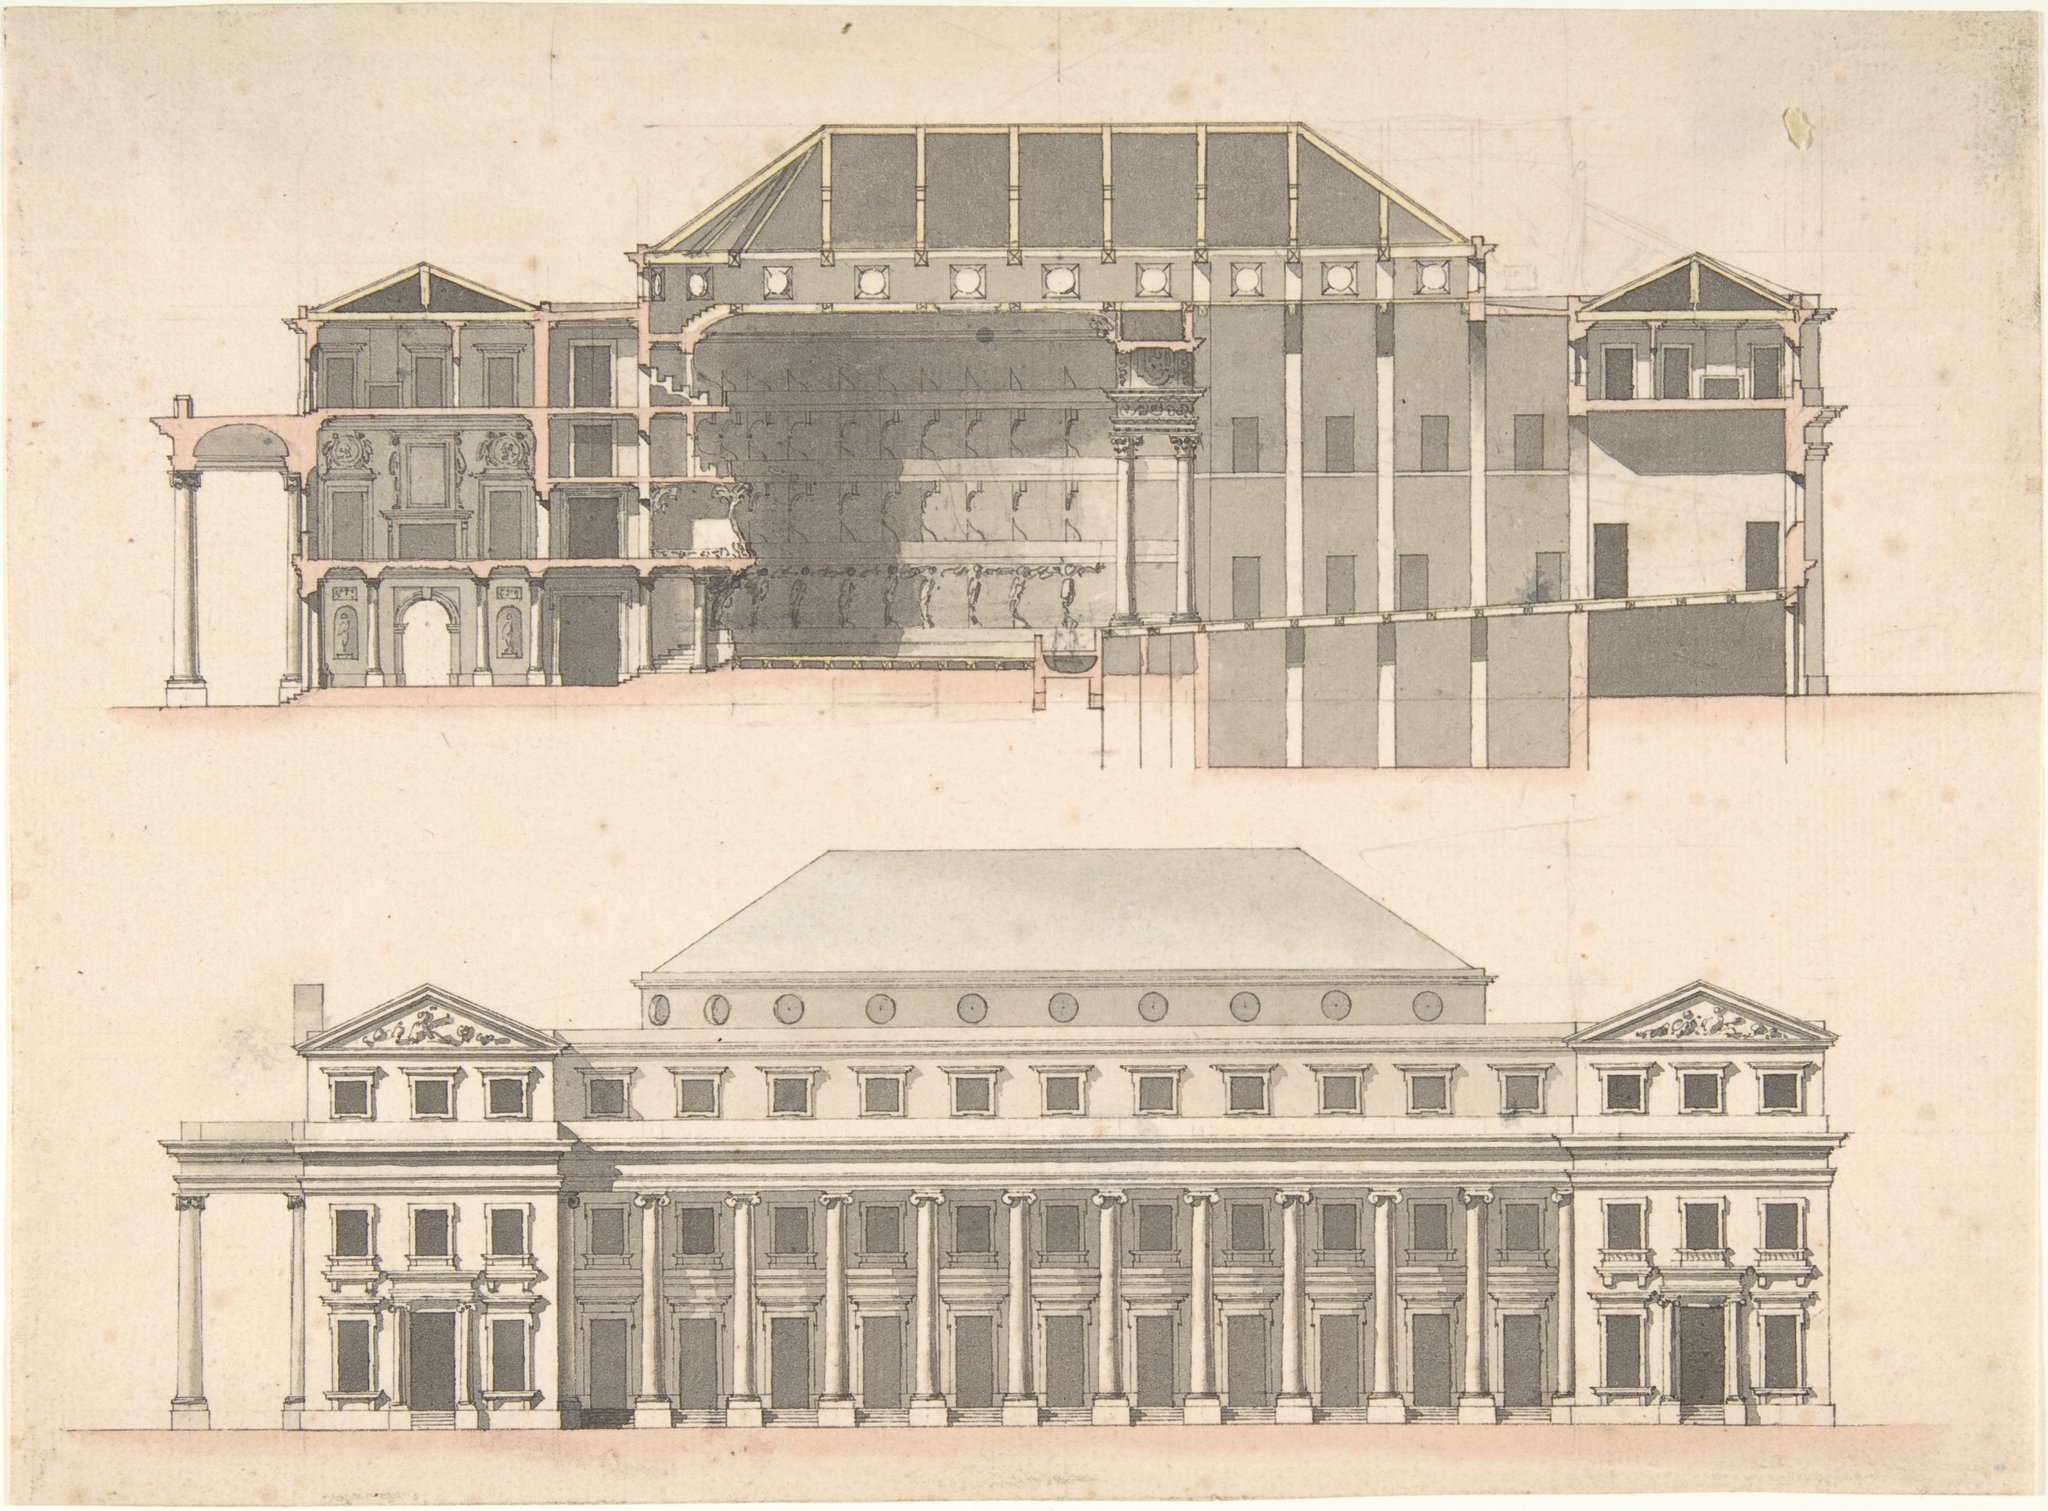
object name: drawing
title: Designs for a Theatre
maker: anonymous, french, 18th century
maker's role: artist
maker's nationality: french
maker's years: 1700-1800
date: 1767-1800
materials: graphite, ink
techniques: brush, pen, wash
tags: theatre,architecture